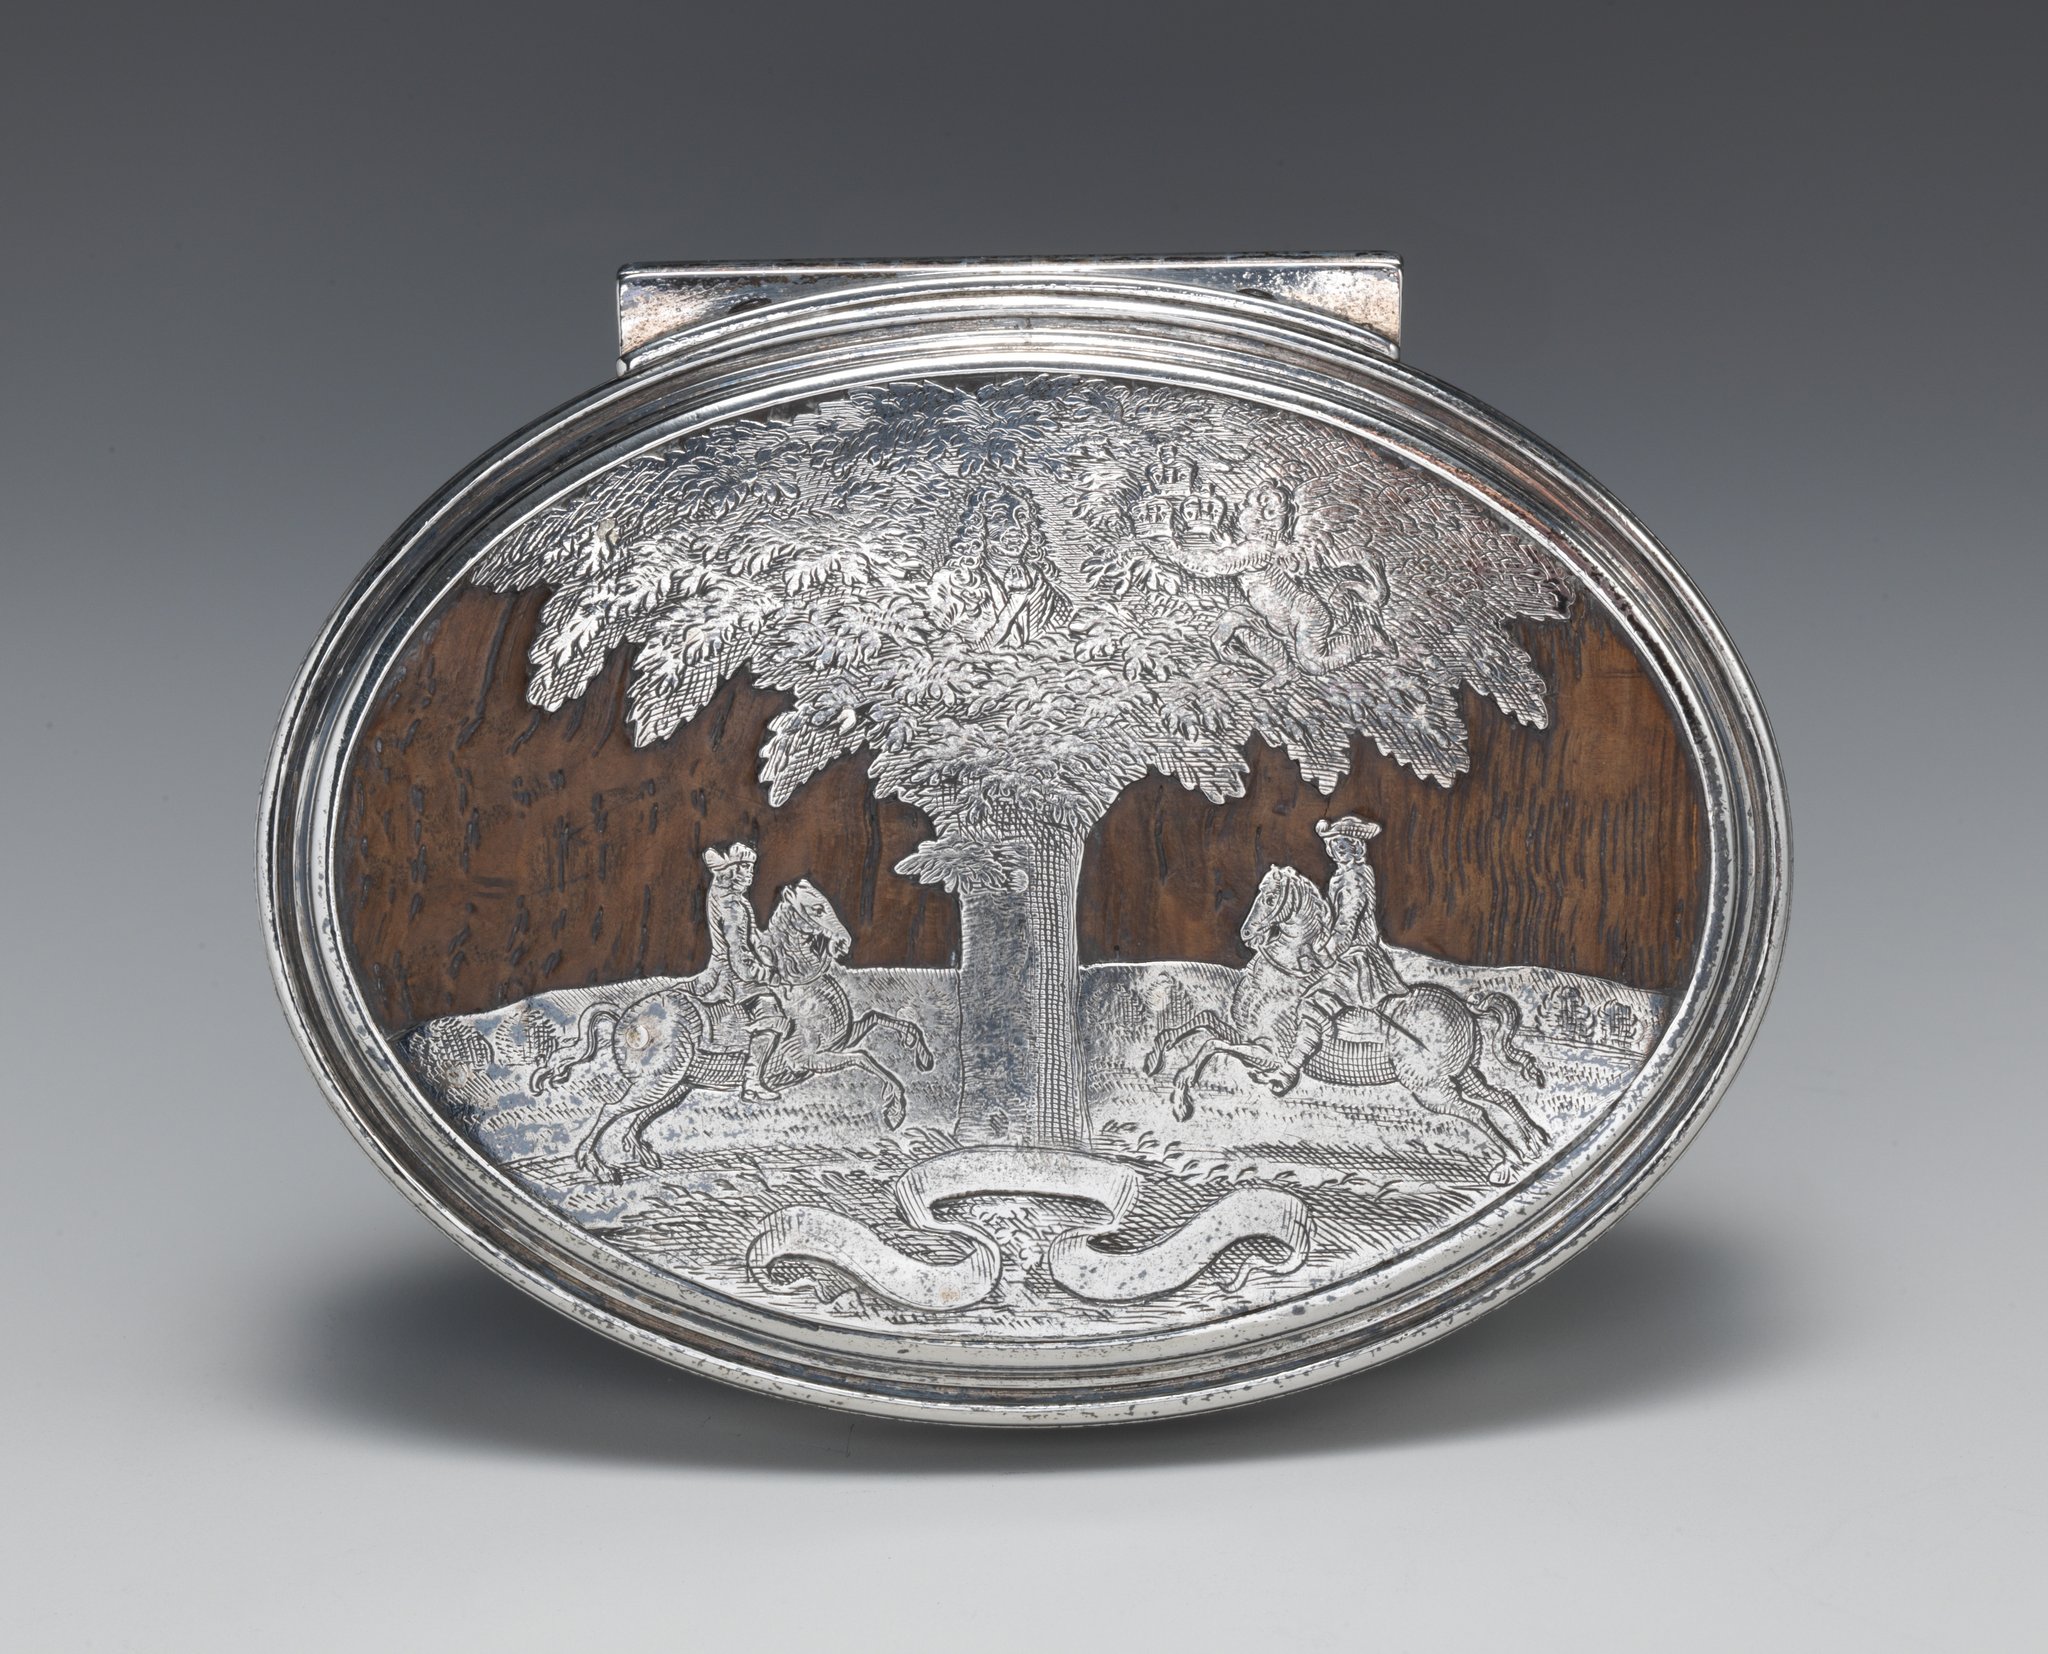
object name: snuffbox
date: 1700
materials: wood, silver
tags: men,horses,trees